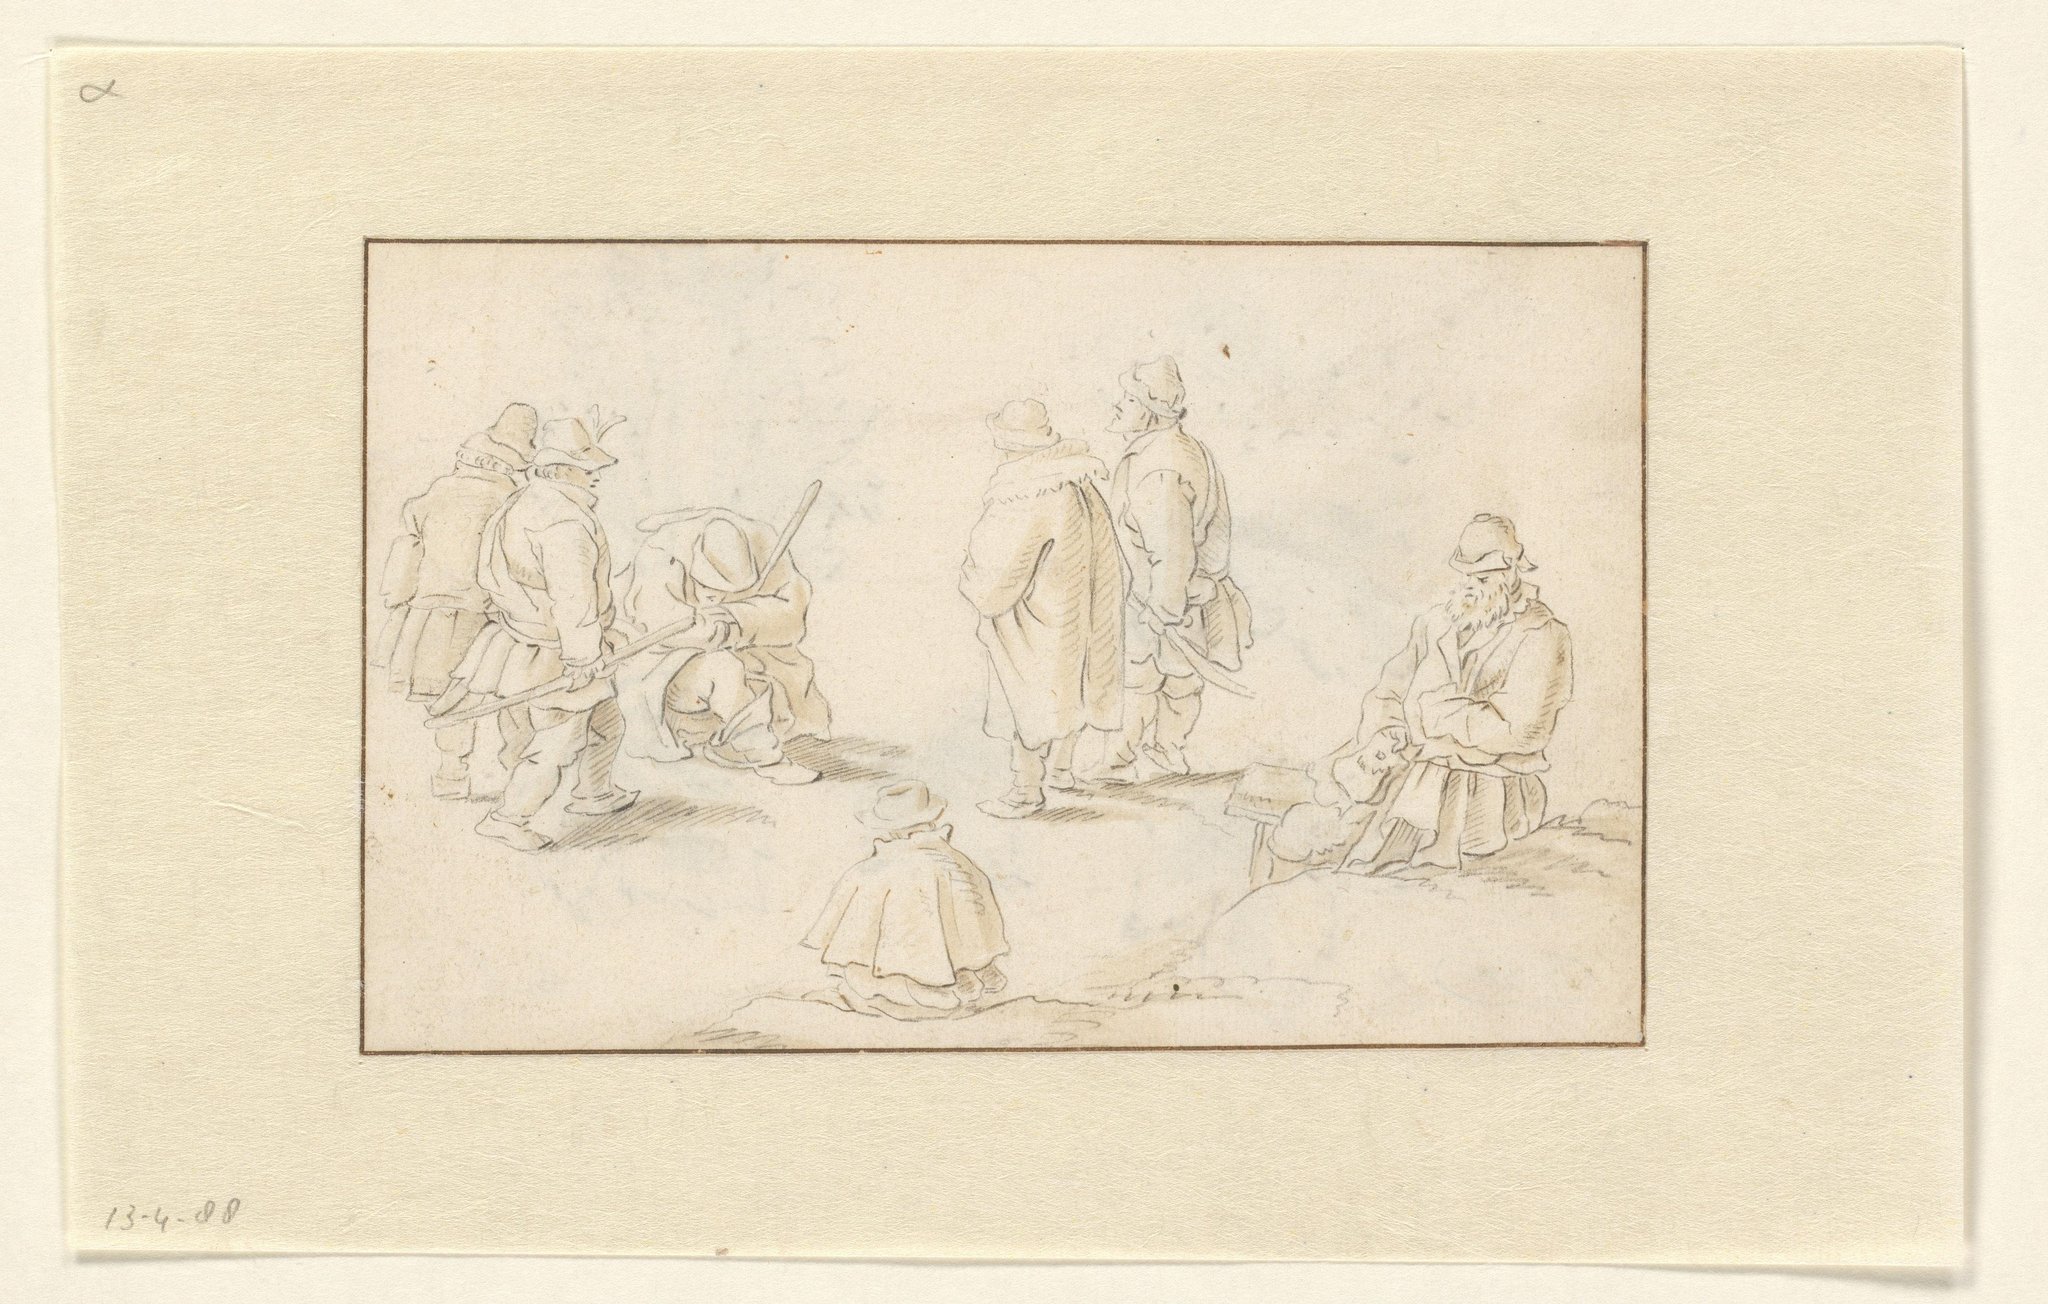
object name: drawing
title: Zeven mannen, staand, zittend en lopend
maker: herman saftleven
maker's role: draughtsman, painter, print maker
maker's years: 1609-1685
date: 1619-1685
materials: chalk, paper, pencil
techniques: brush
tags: standing figure, sitting figure, walking